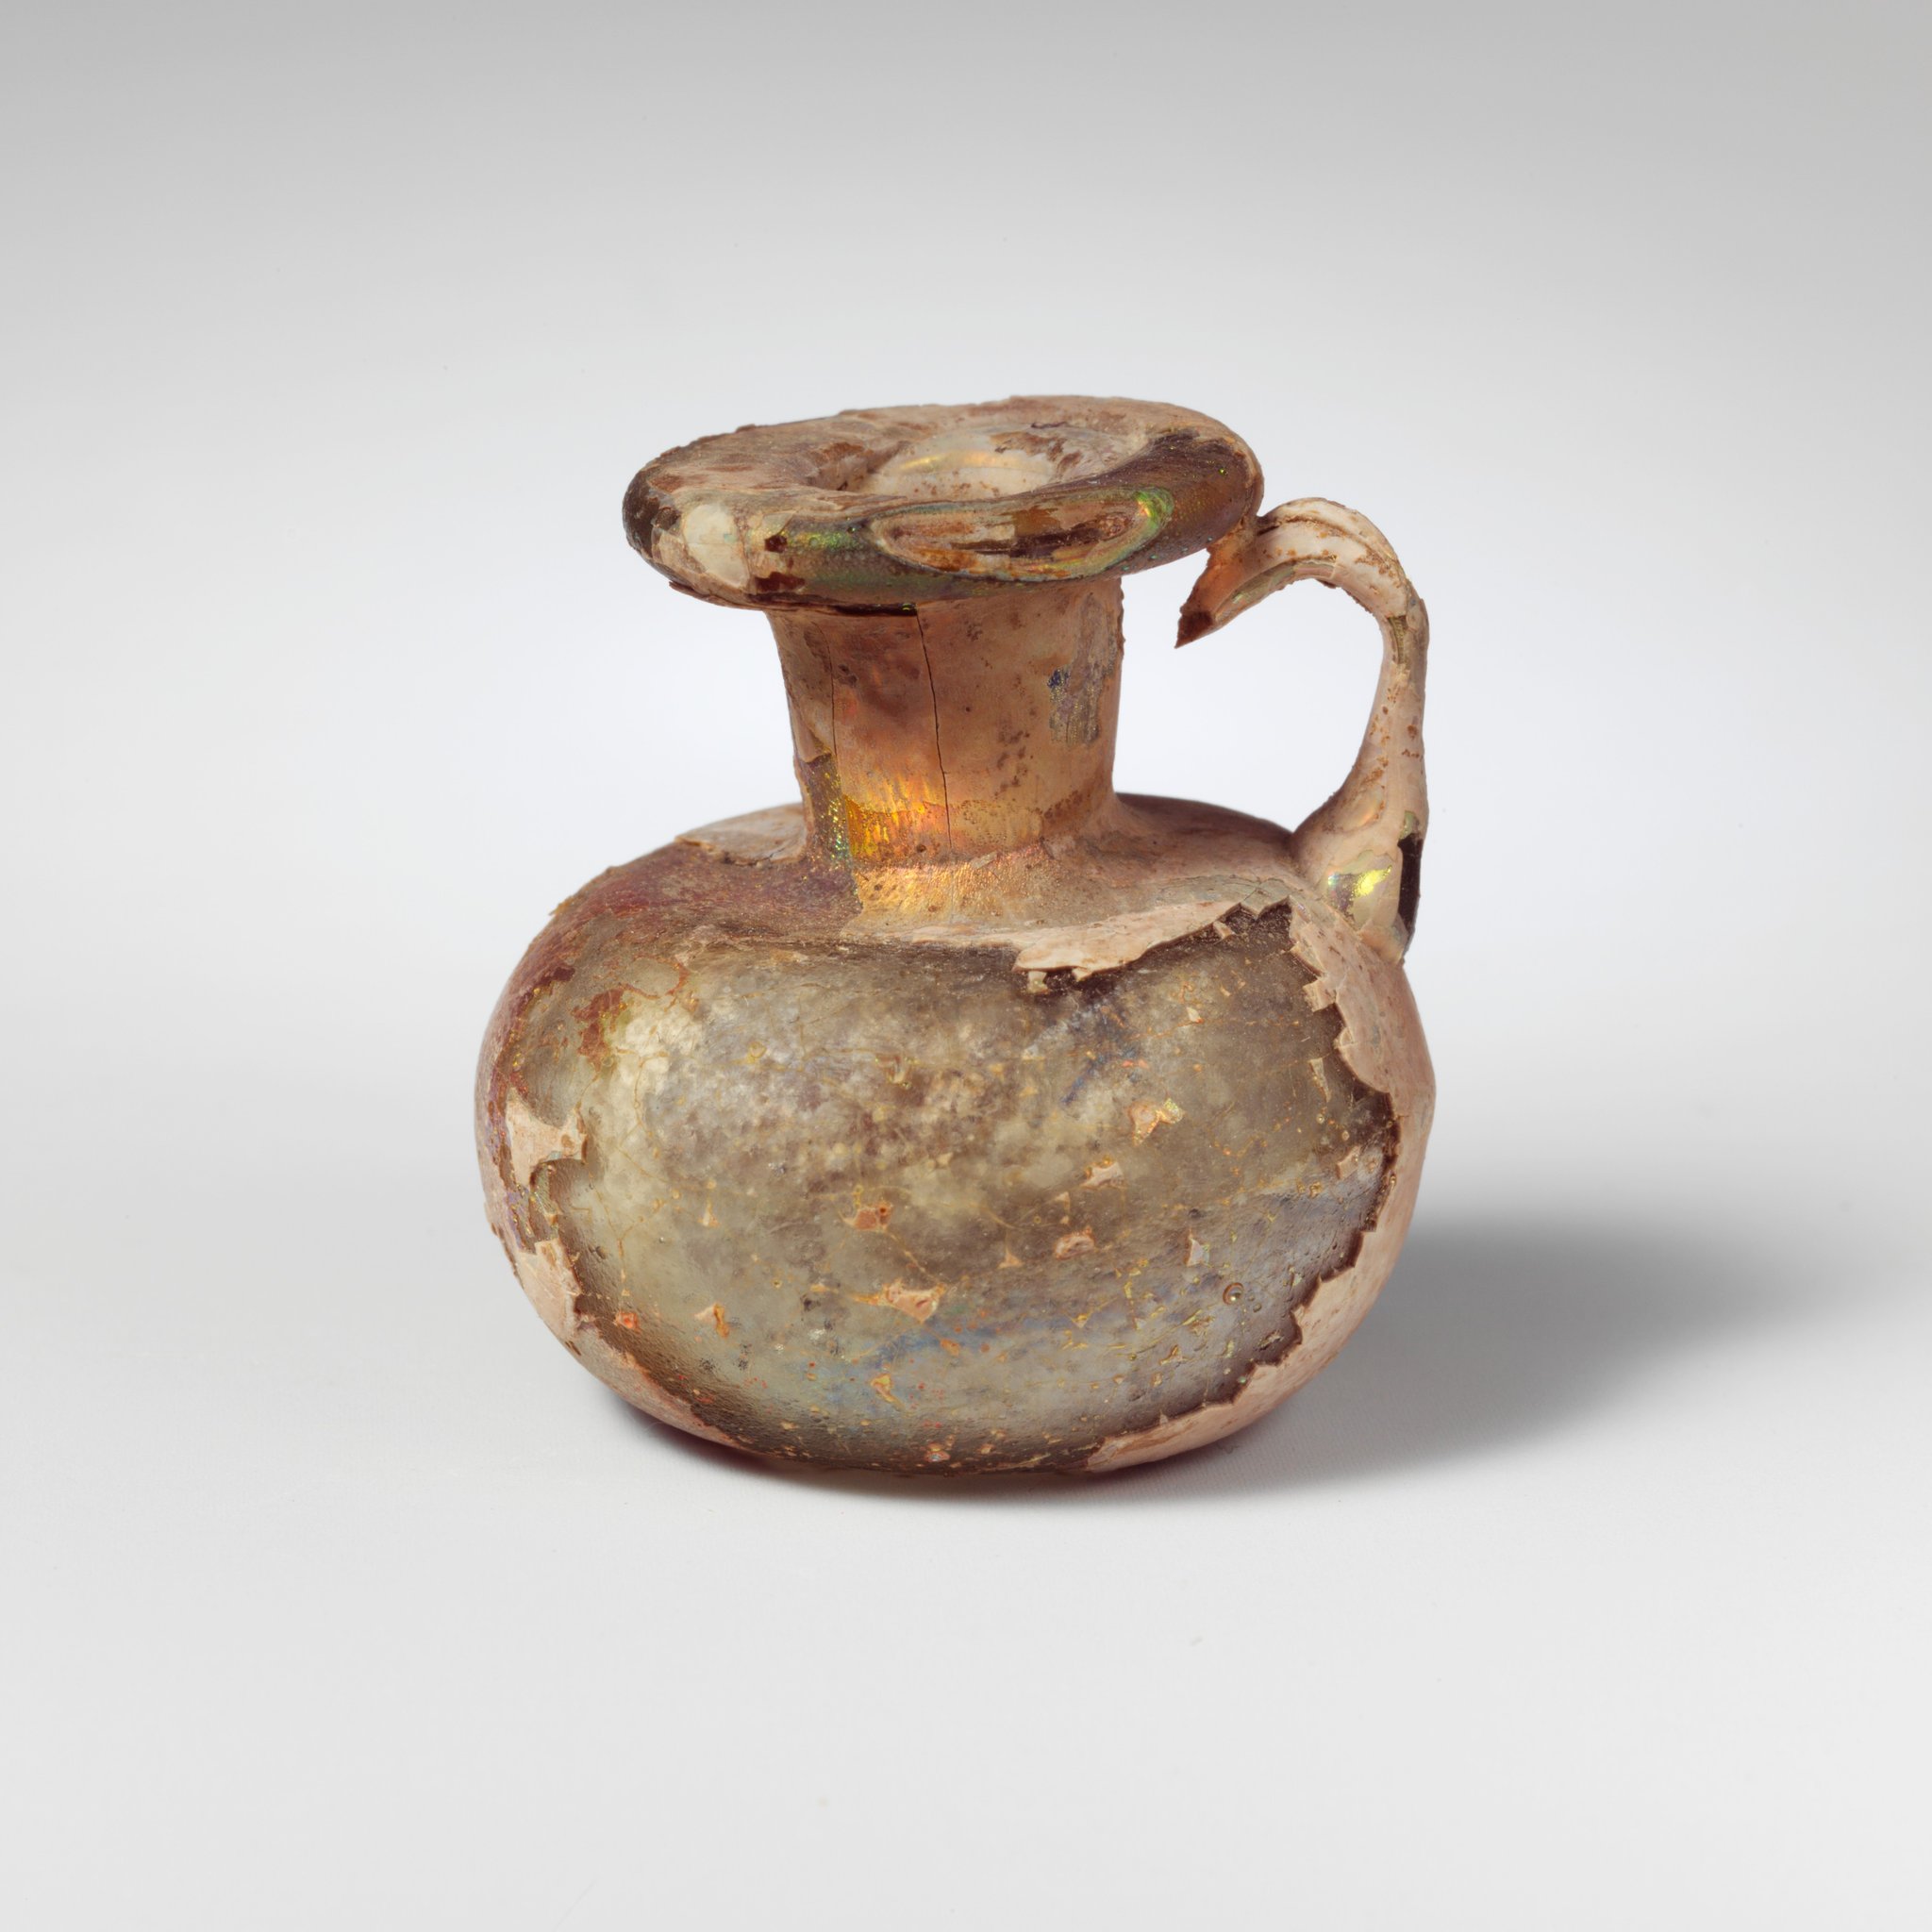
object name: bottle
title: Glass one-handled miniature bottle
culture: roman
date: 101-300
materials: glass